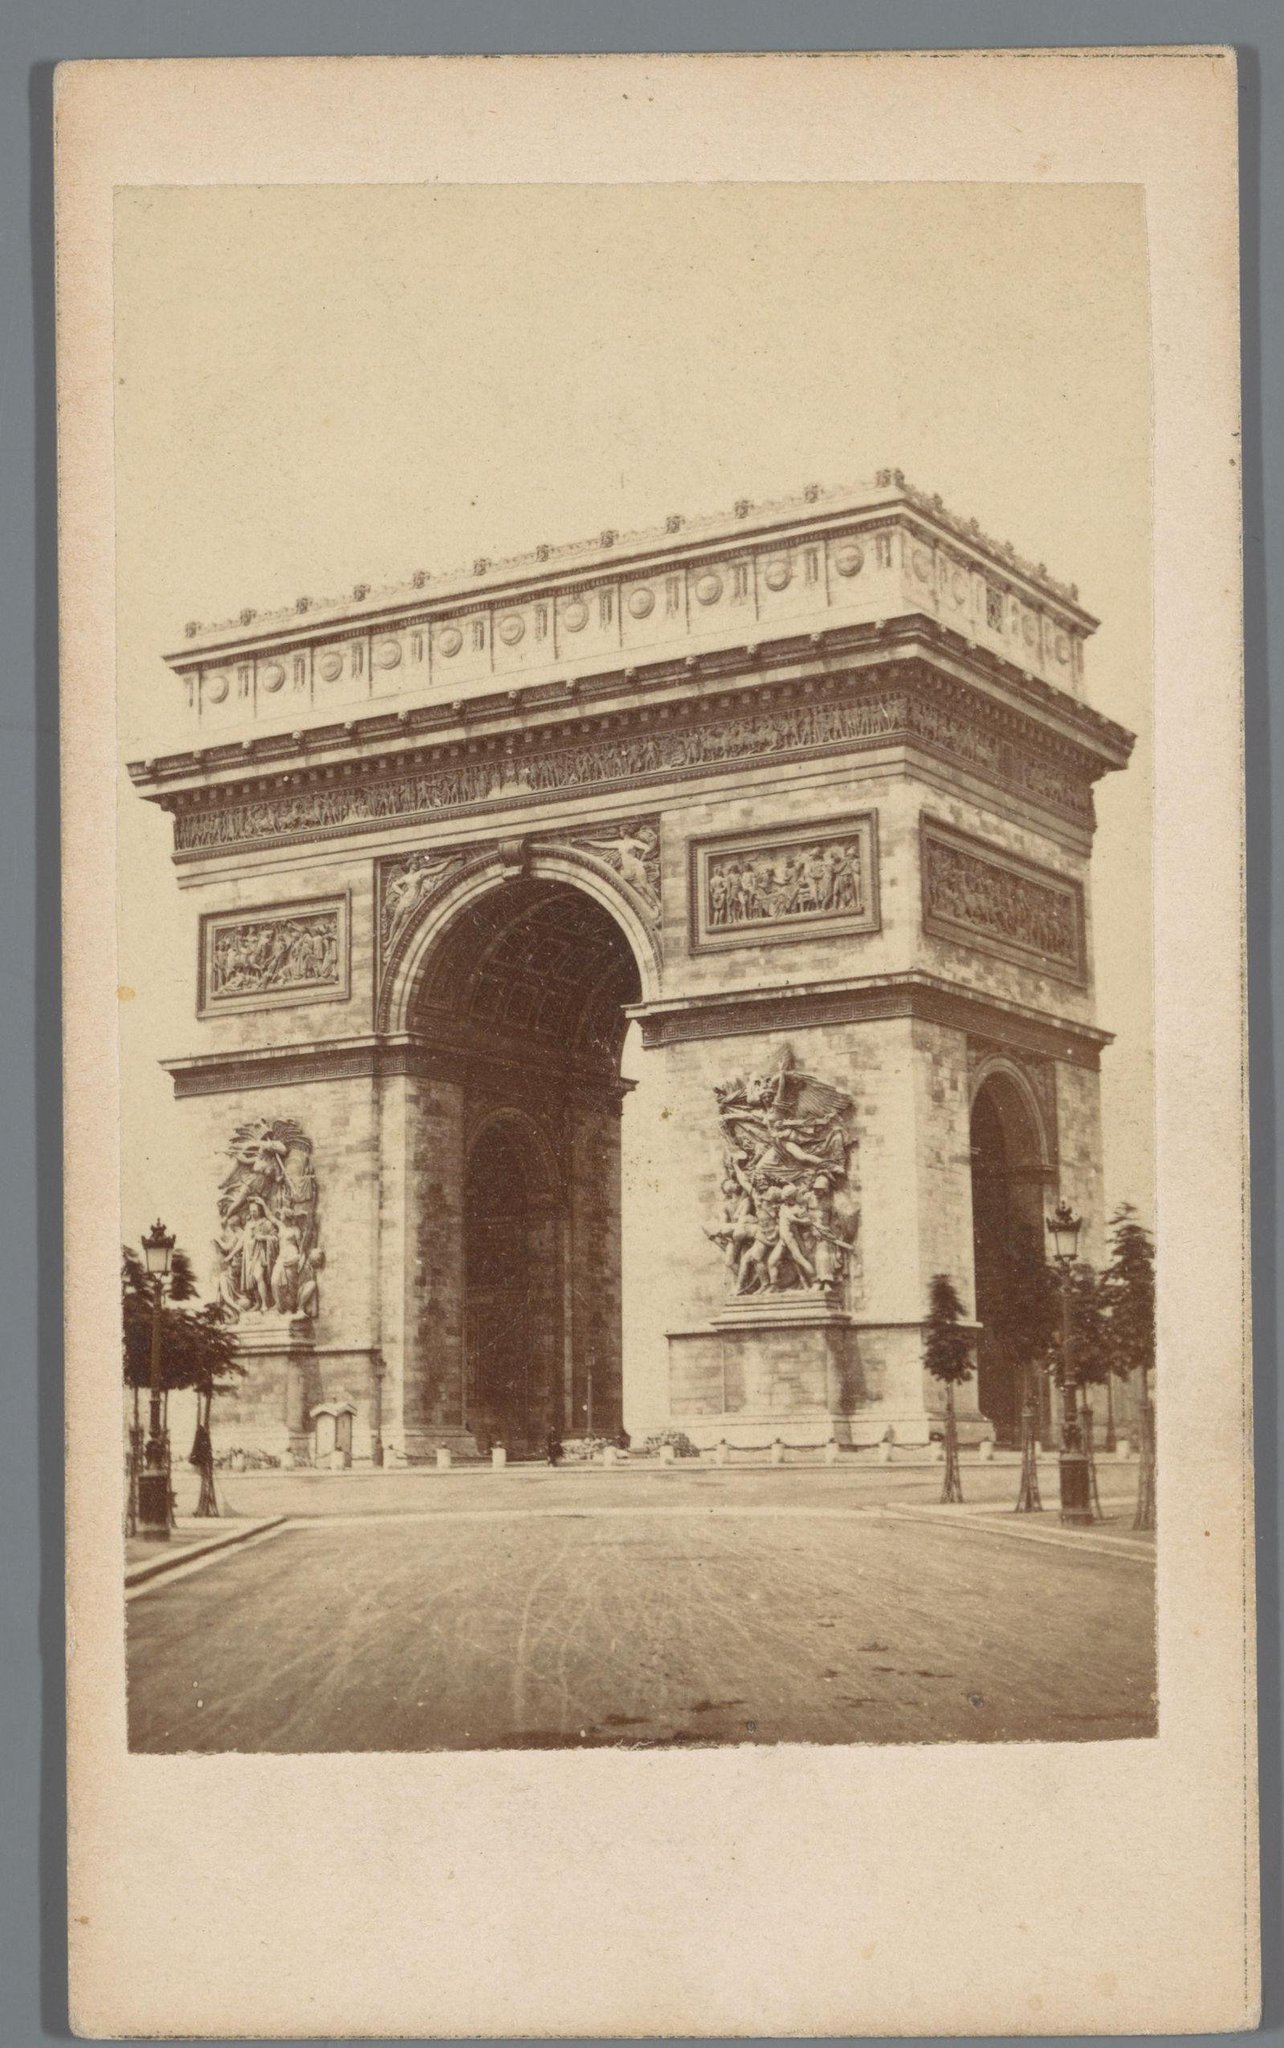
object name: photograph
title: Arc de Triomphe de l'Etoile, Paris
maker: guerard ainé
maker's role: fotograaf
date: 1855-1885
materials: cardboard, paper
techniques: albumen print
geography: paris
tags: triumphal arch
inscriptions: address: ‘RUE DU DAUPHIN, No. 2./ au Coin de celle Rivoli/ GUÉRARD AÎNE/ DEPÔT DE PHOTOGRAPHIES/ Choix immenses de Portrait Cartes/ et Vues Stéréoscopiques de tous pays.’